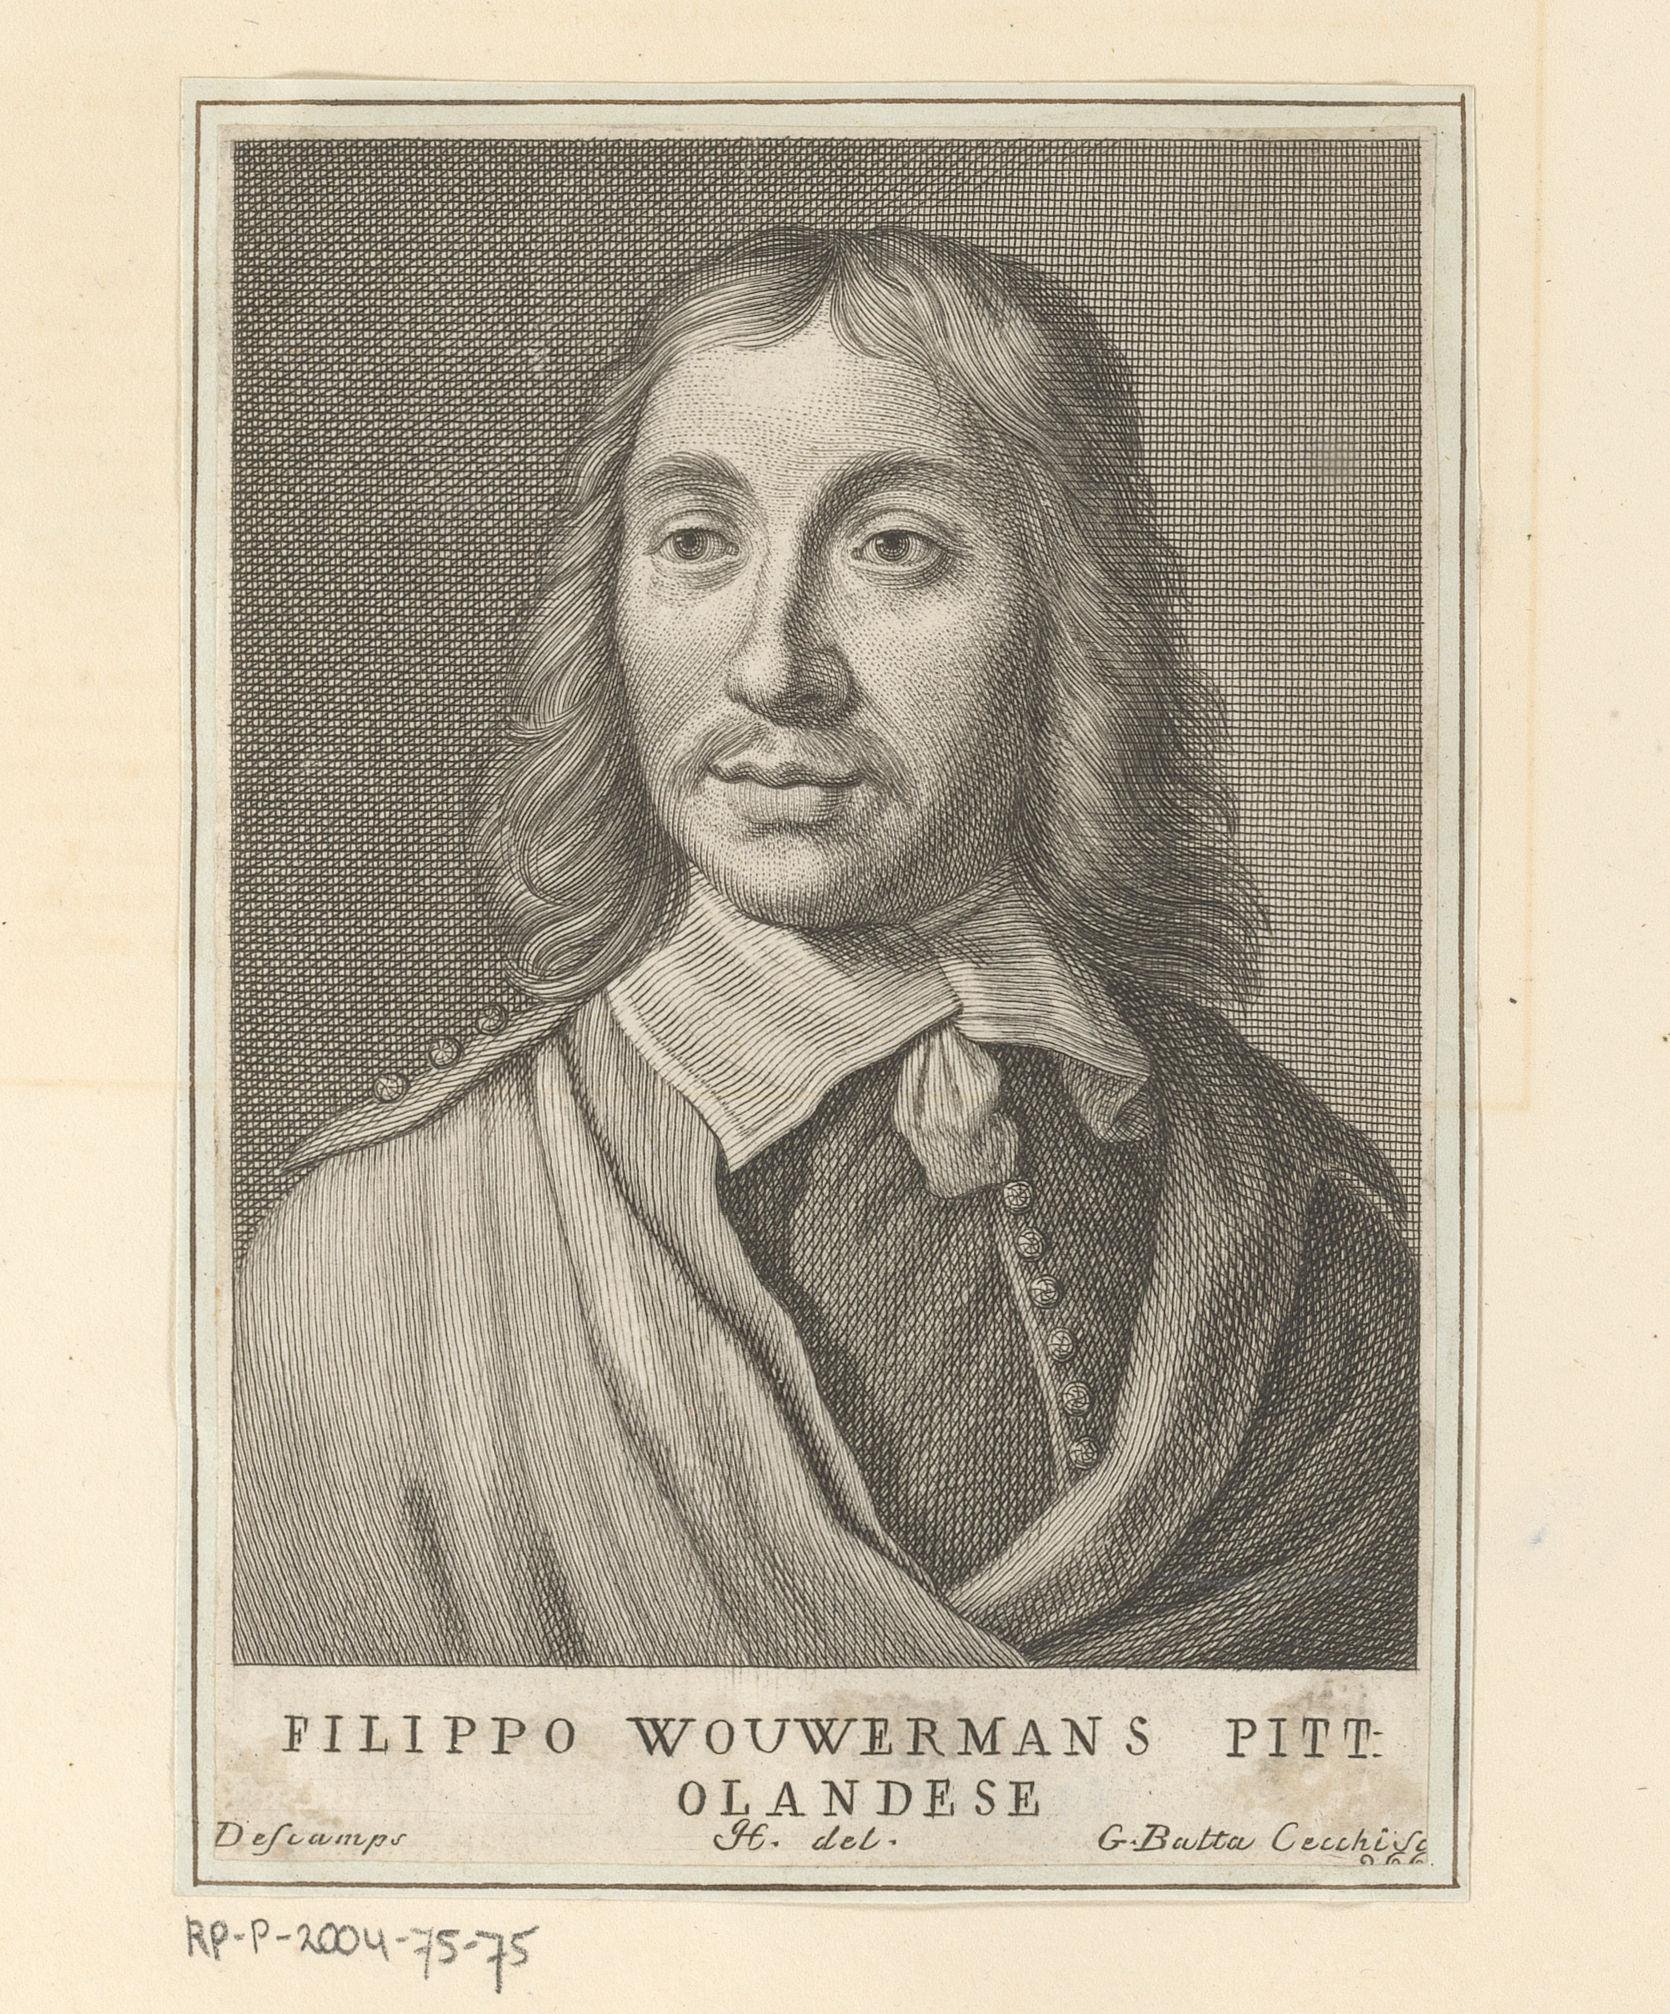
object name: print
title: Portret van Philips Wouwerman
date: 1769-1775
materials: paper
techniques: engraving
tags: painter, philips wouwerman, historical persons, portrait, self-portrait of painter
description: Prent is onderdeel van een serie getiteld 'Serie degli Uomini ', en bestaat uit 12 delen uitgegeven tussen 1769 en 1775. Ieder deel is onderverdeeld in verschillende hoofdstukken, elk bestaande uit de lofrede op een kunstenaar voorafgegaan door een gegraveerd portret van de kunstenaar. De samensteller heeft deze prent in het album geplakt als illustratie bij: Pilkington, Matthew en Johann Heinrich Füssli. A dictionary of painters, from the revival of the art to the present period. 4 dln. Londen: John Crowder, 1805, dl. 4, p. 655.